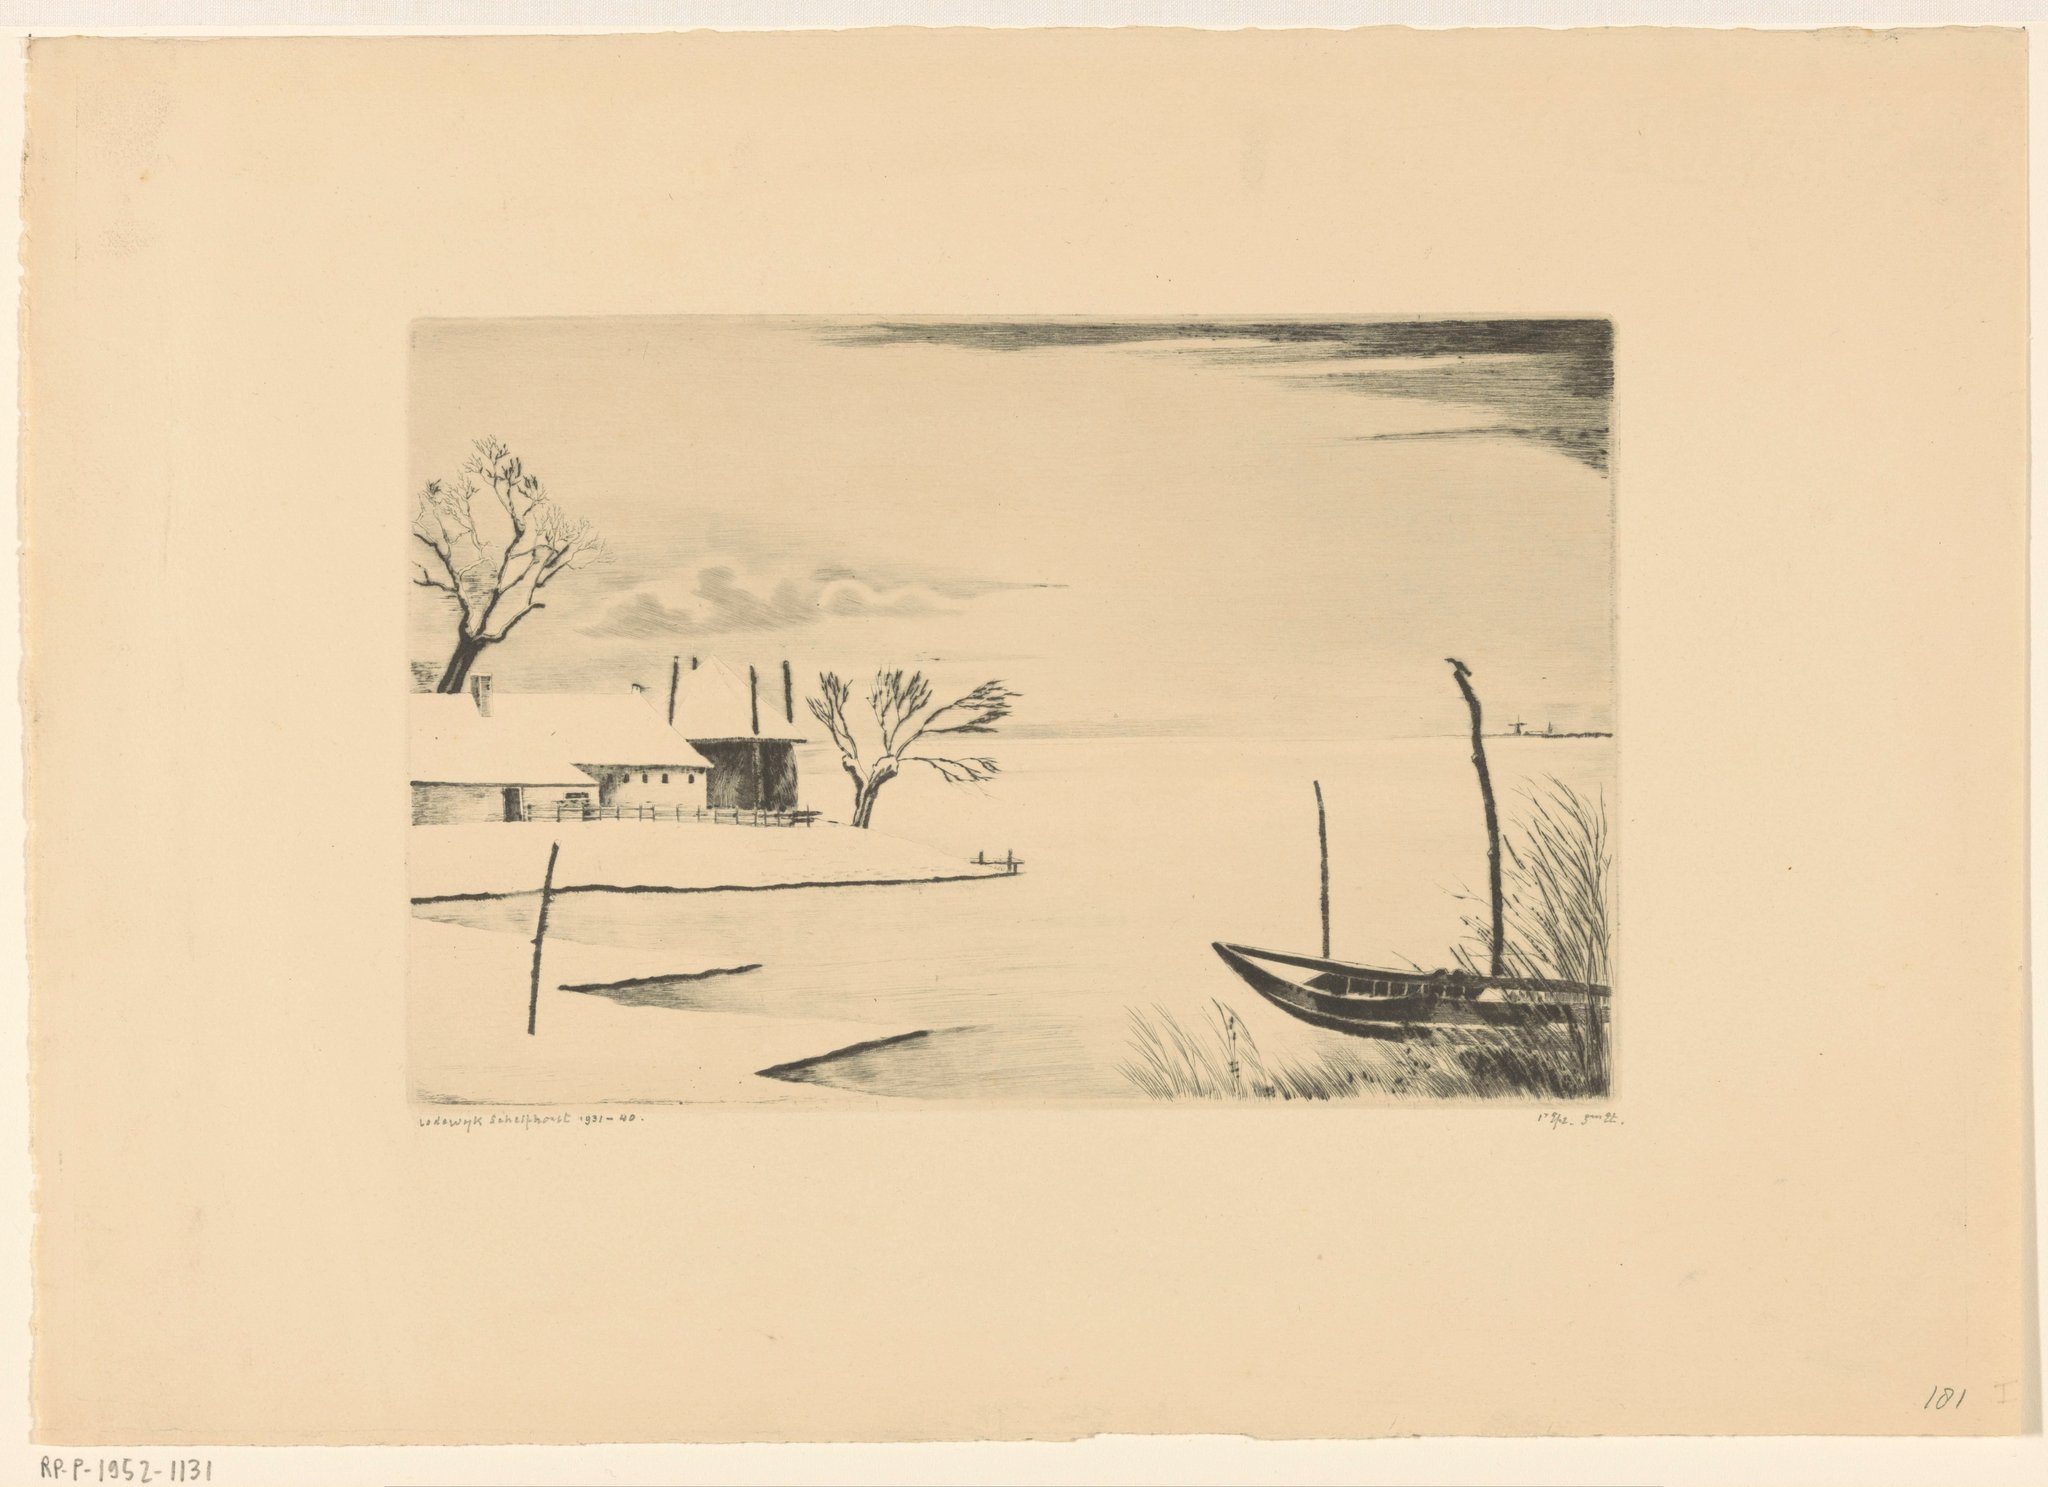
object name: print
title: Boerderij in een winterlandschap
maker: lodewijk schelfhout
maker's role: draughtsman, print maker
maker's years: 1881-1943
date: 1931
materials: paper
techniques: drypoint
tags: lake, winter landscape; landscape symbolizing winter (the four seasons of the year), farm or solitary house in landscape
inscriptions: collector's mark: Lugt 2228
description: Een boerderij met hooischuur aan een meer in een besneeuwd landschap. Rechts op de voorgrond een afgemeerde schuit.